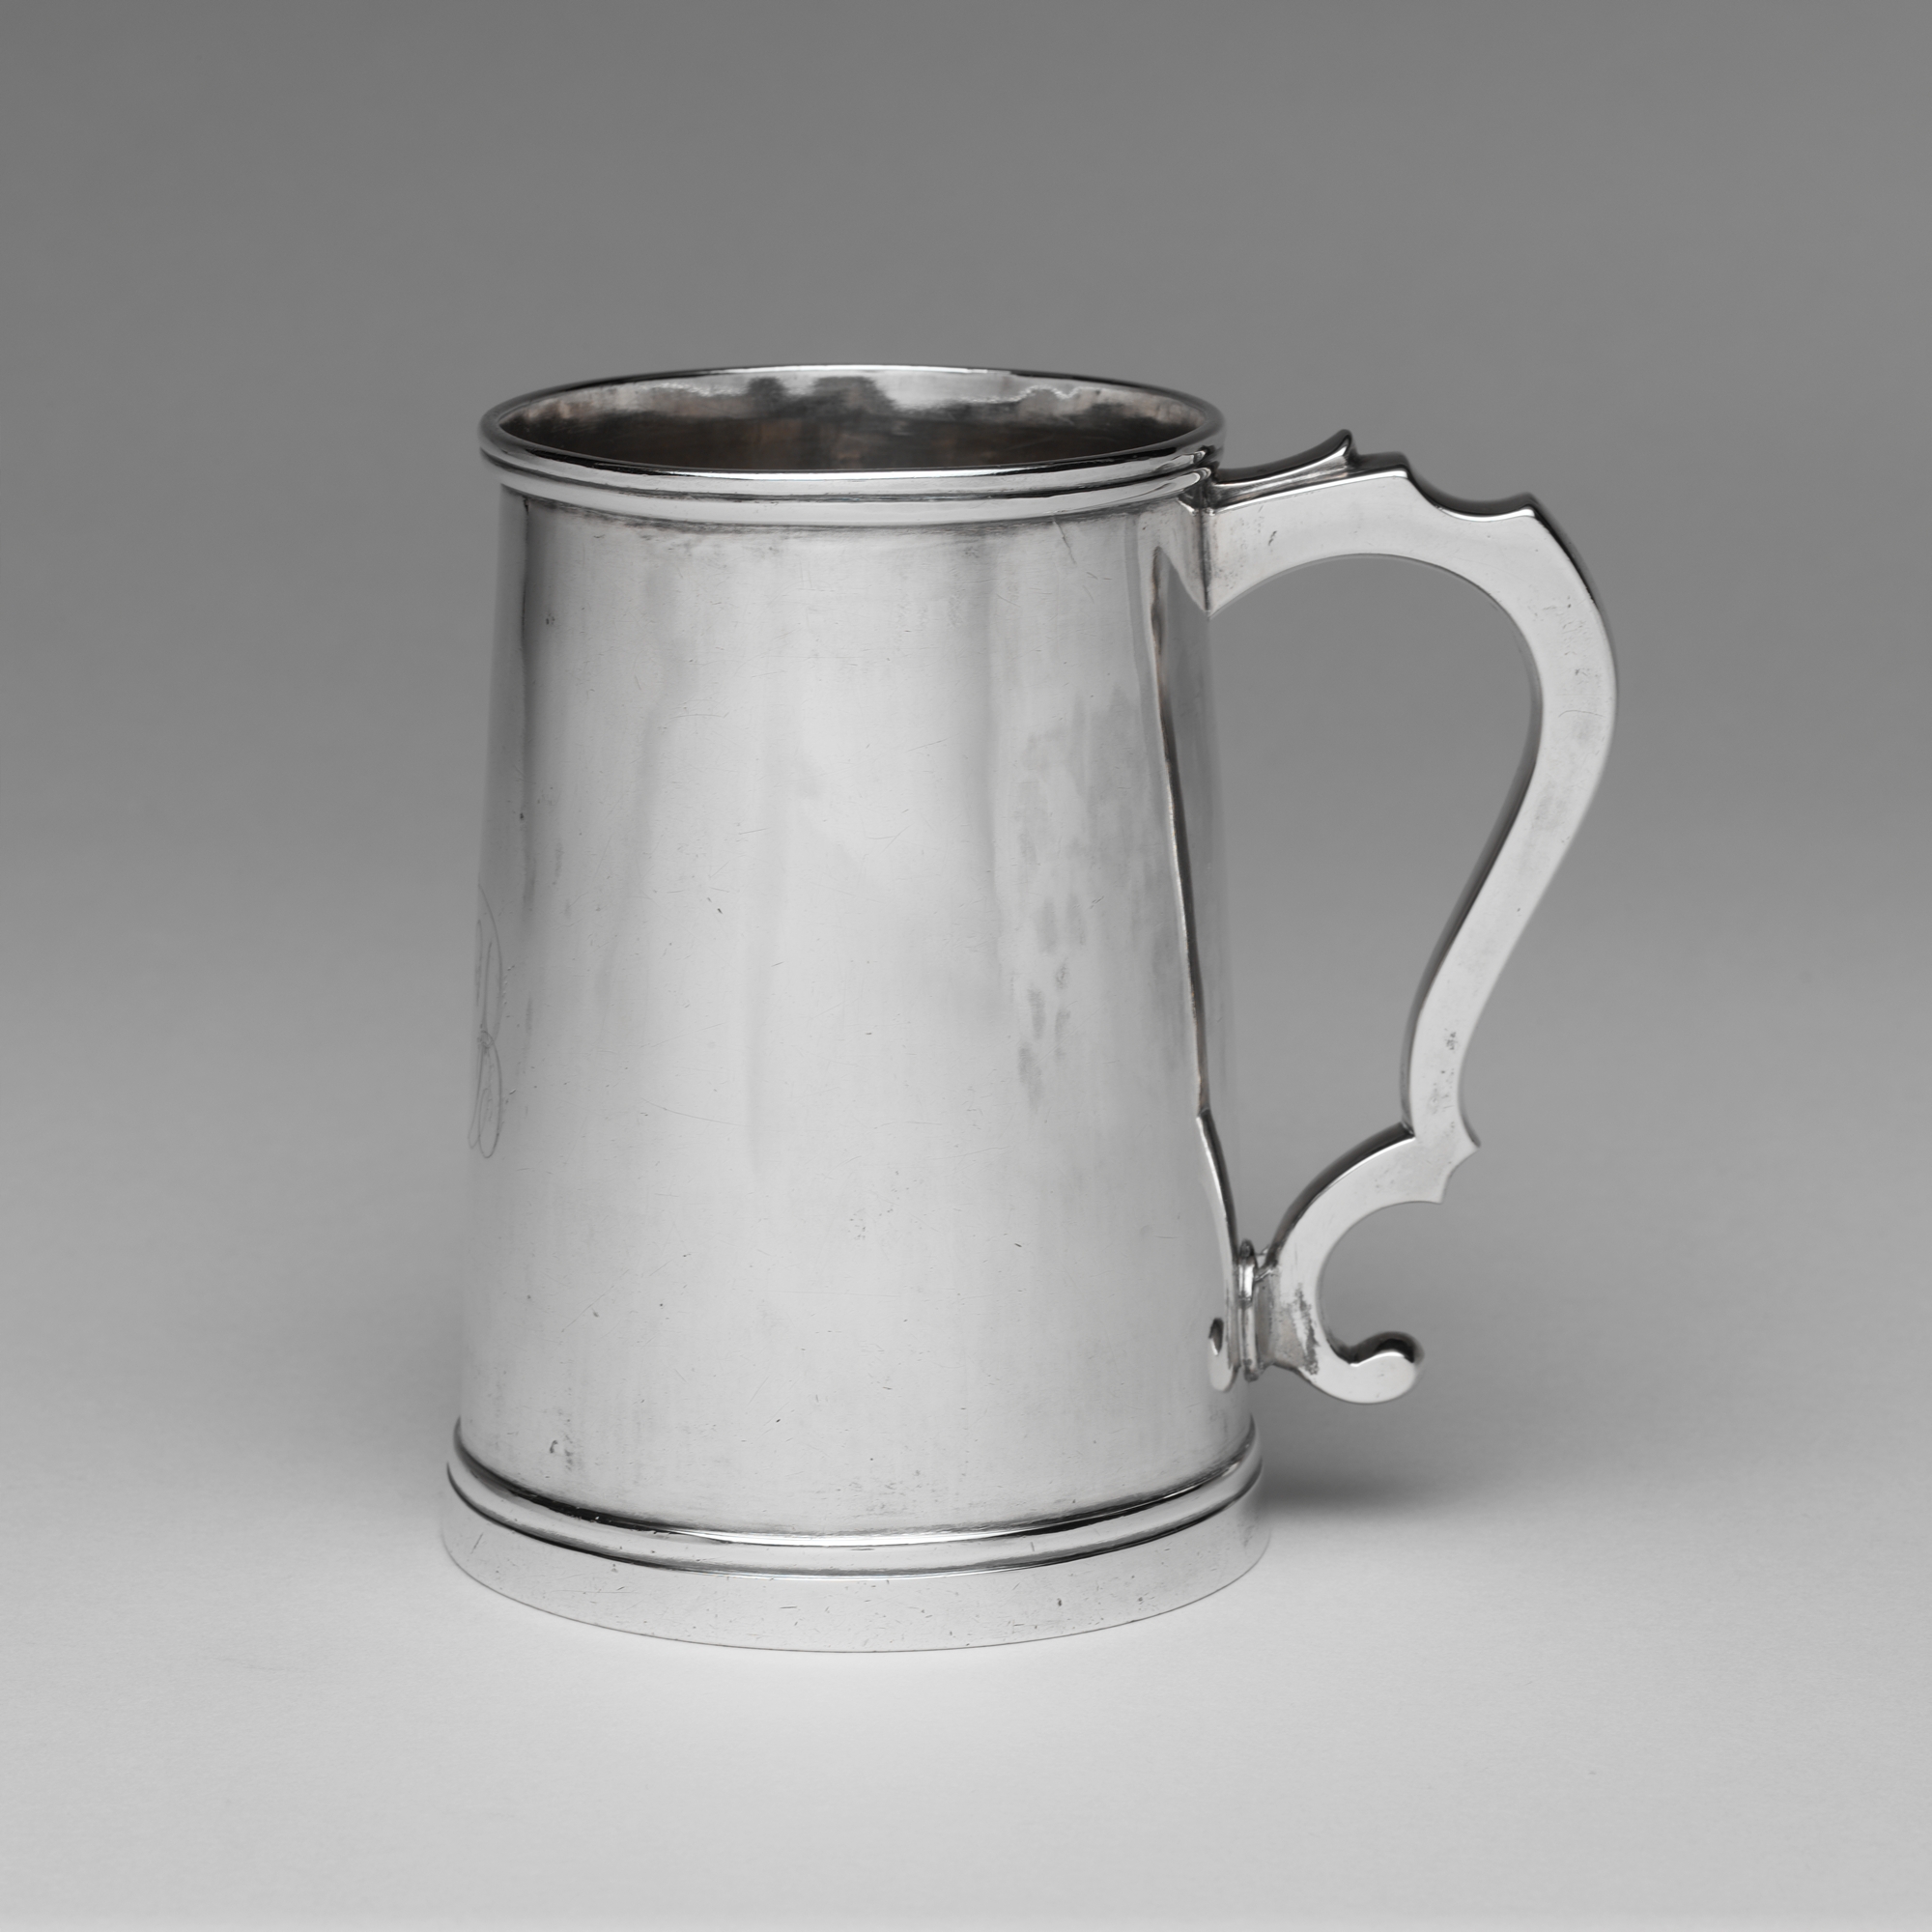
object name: mug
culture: american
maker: william moulton, iv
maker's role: maker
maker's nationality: american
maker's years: 1772-1861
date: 1825-1850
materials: silver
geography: united states